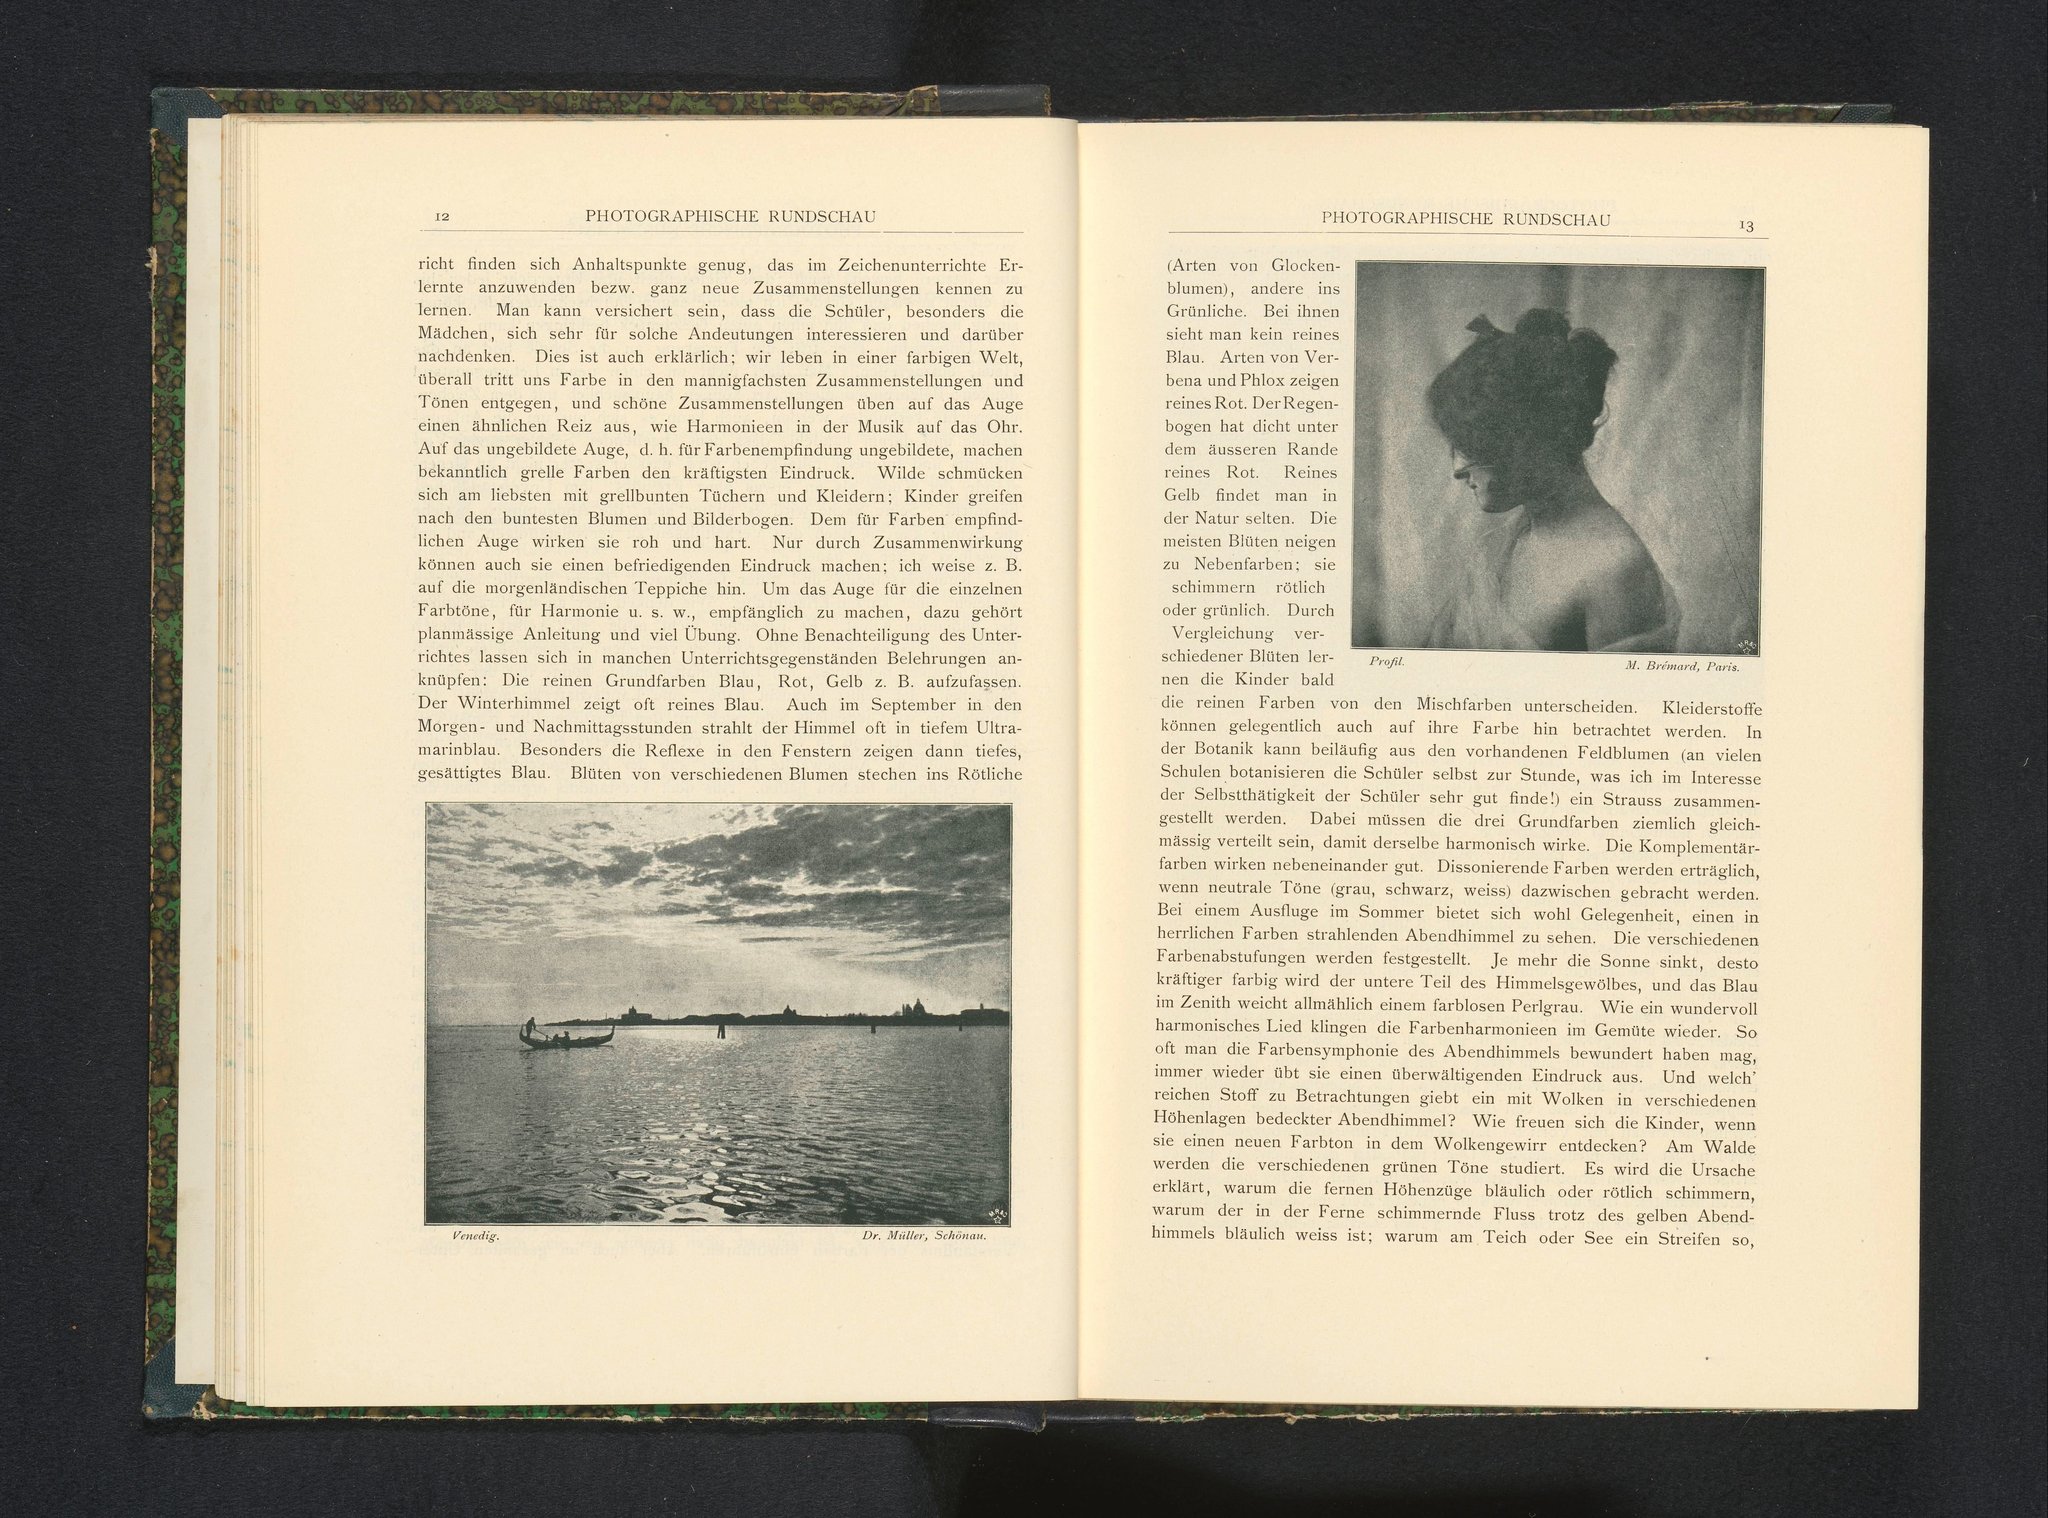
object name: page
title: Profil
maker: maurice brémard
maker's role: fotograaf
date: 1894-1899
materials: paper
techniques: autotype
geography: berlin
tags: anonymous historical person portrayed - bb - woman